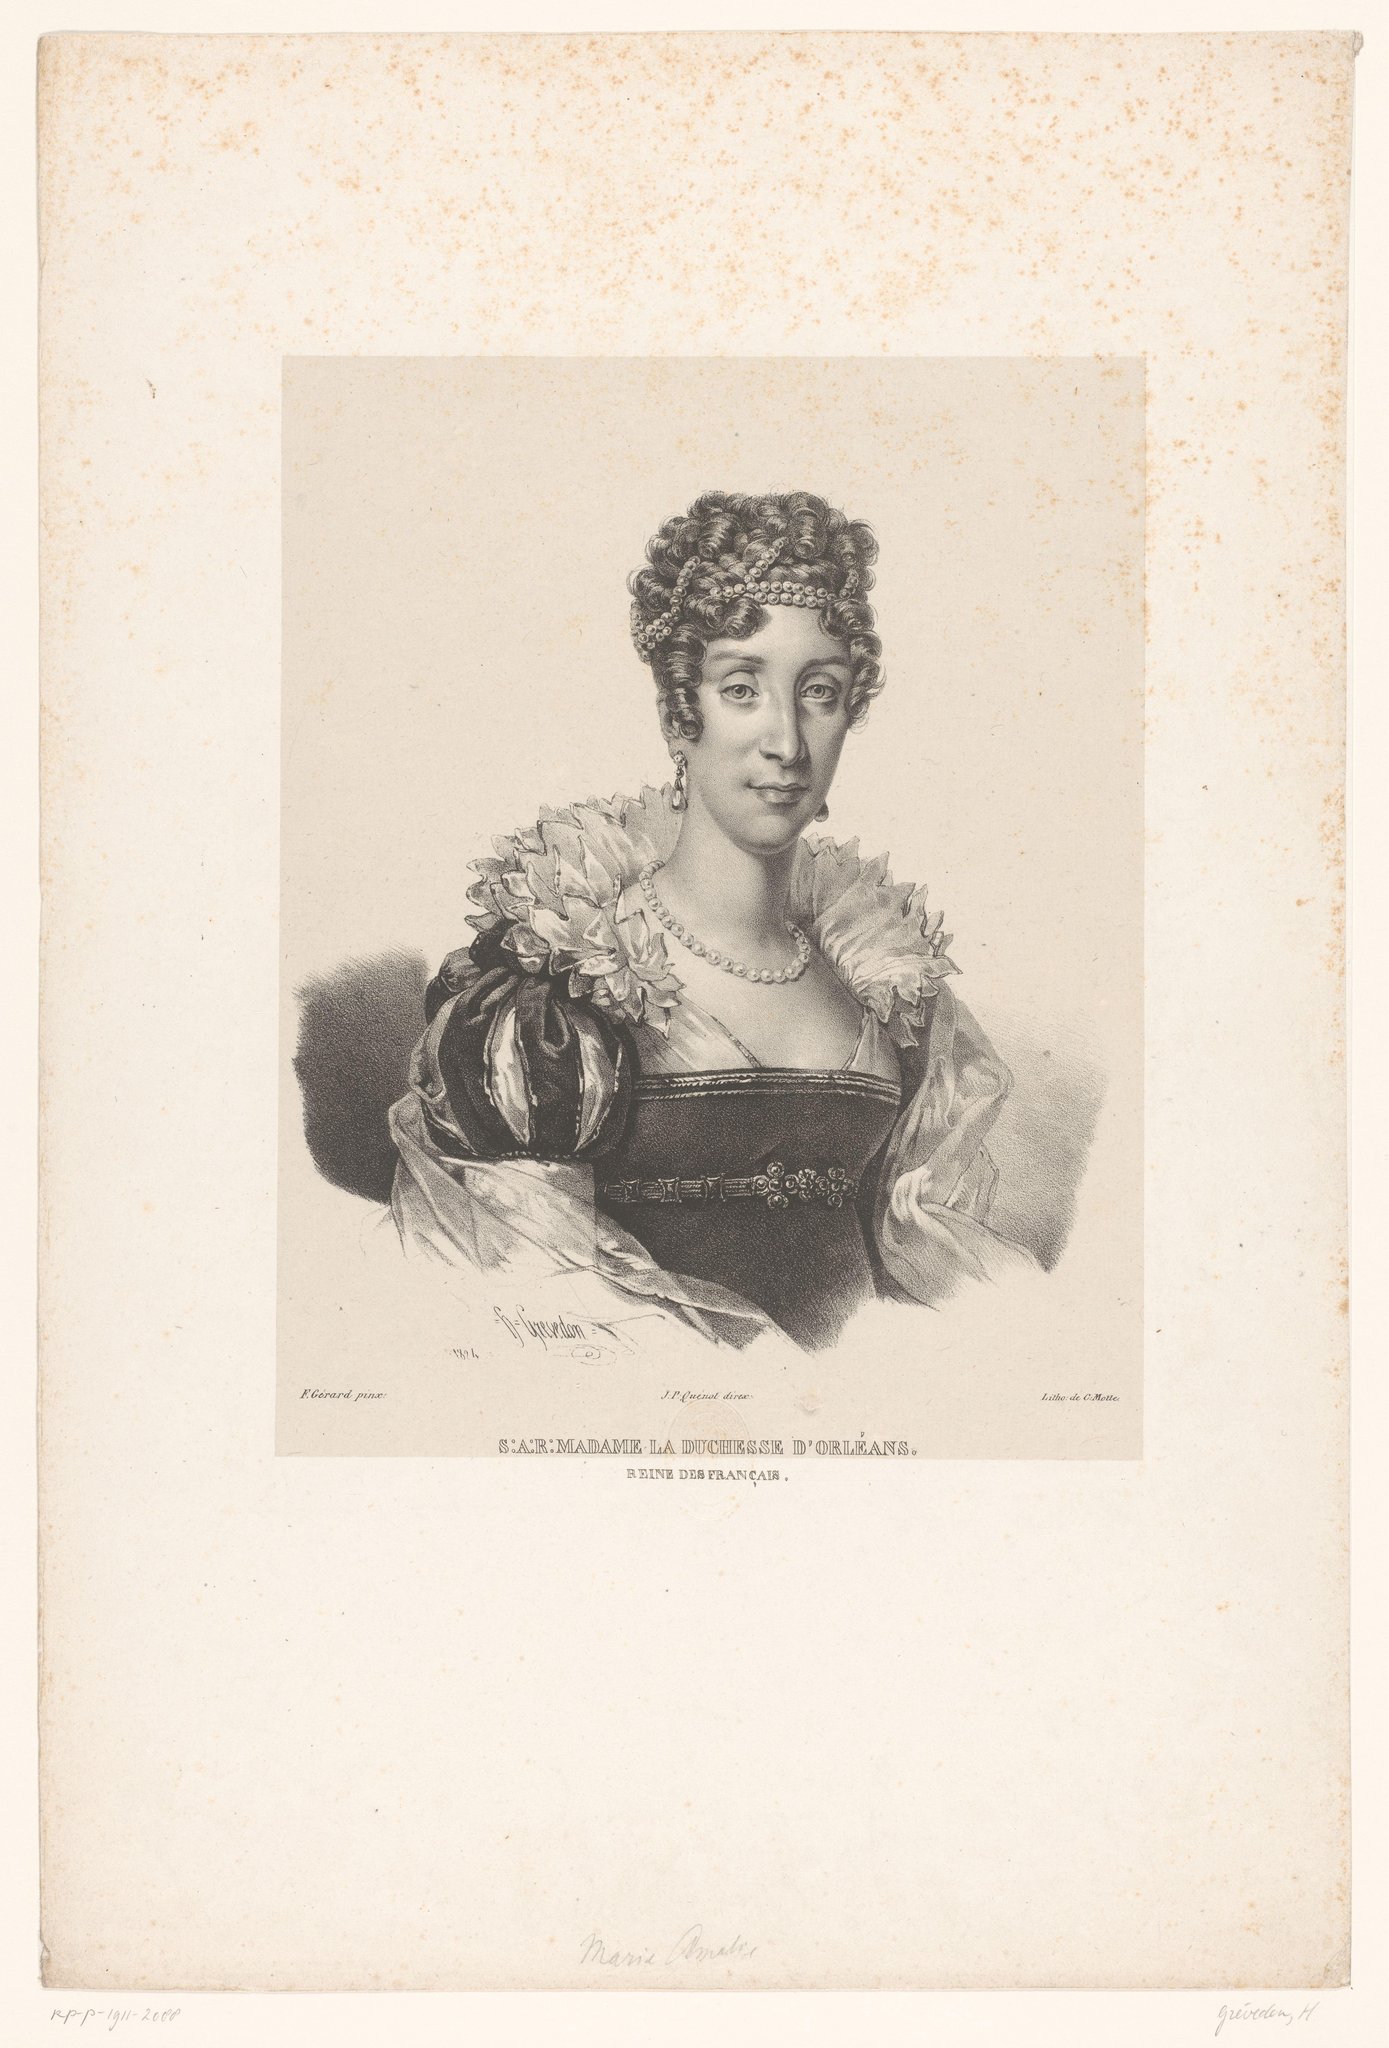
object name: print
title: Portret van Maria Amalia van Bourbon-Sicilië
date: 1824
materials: paper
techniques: lithograph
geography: paris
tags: caserta, london, historical persons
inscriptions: collector's mark: Lugt 2228a, check stamp: Lugt 1999d